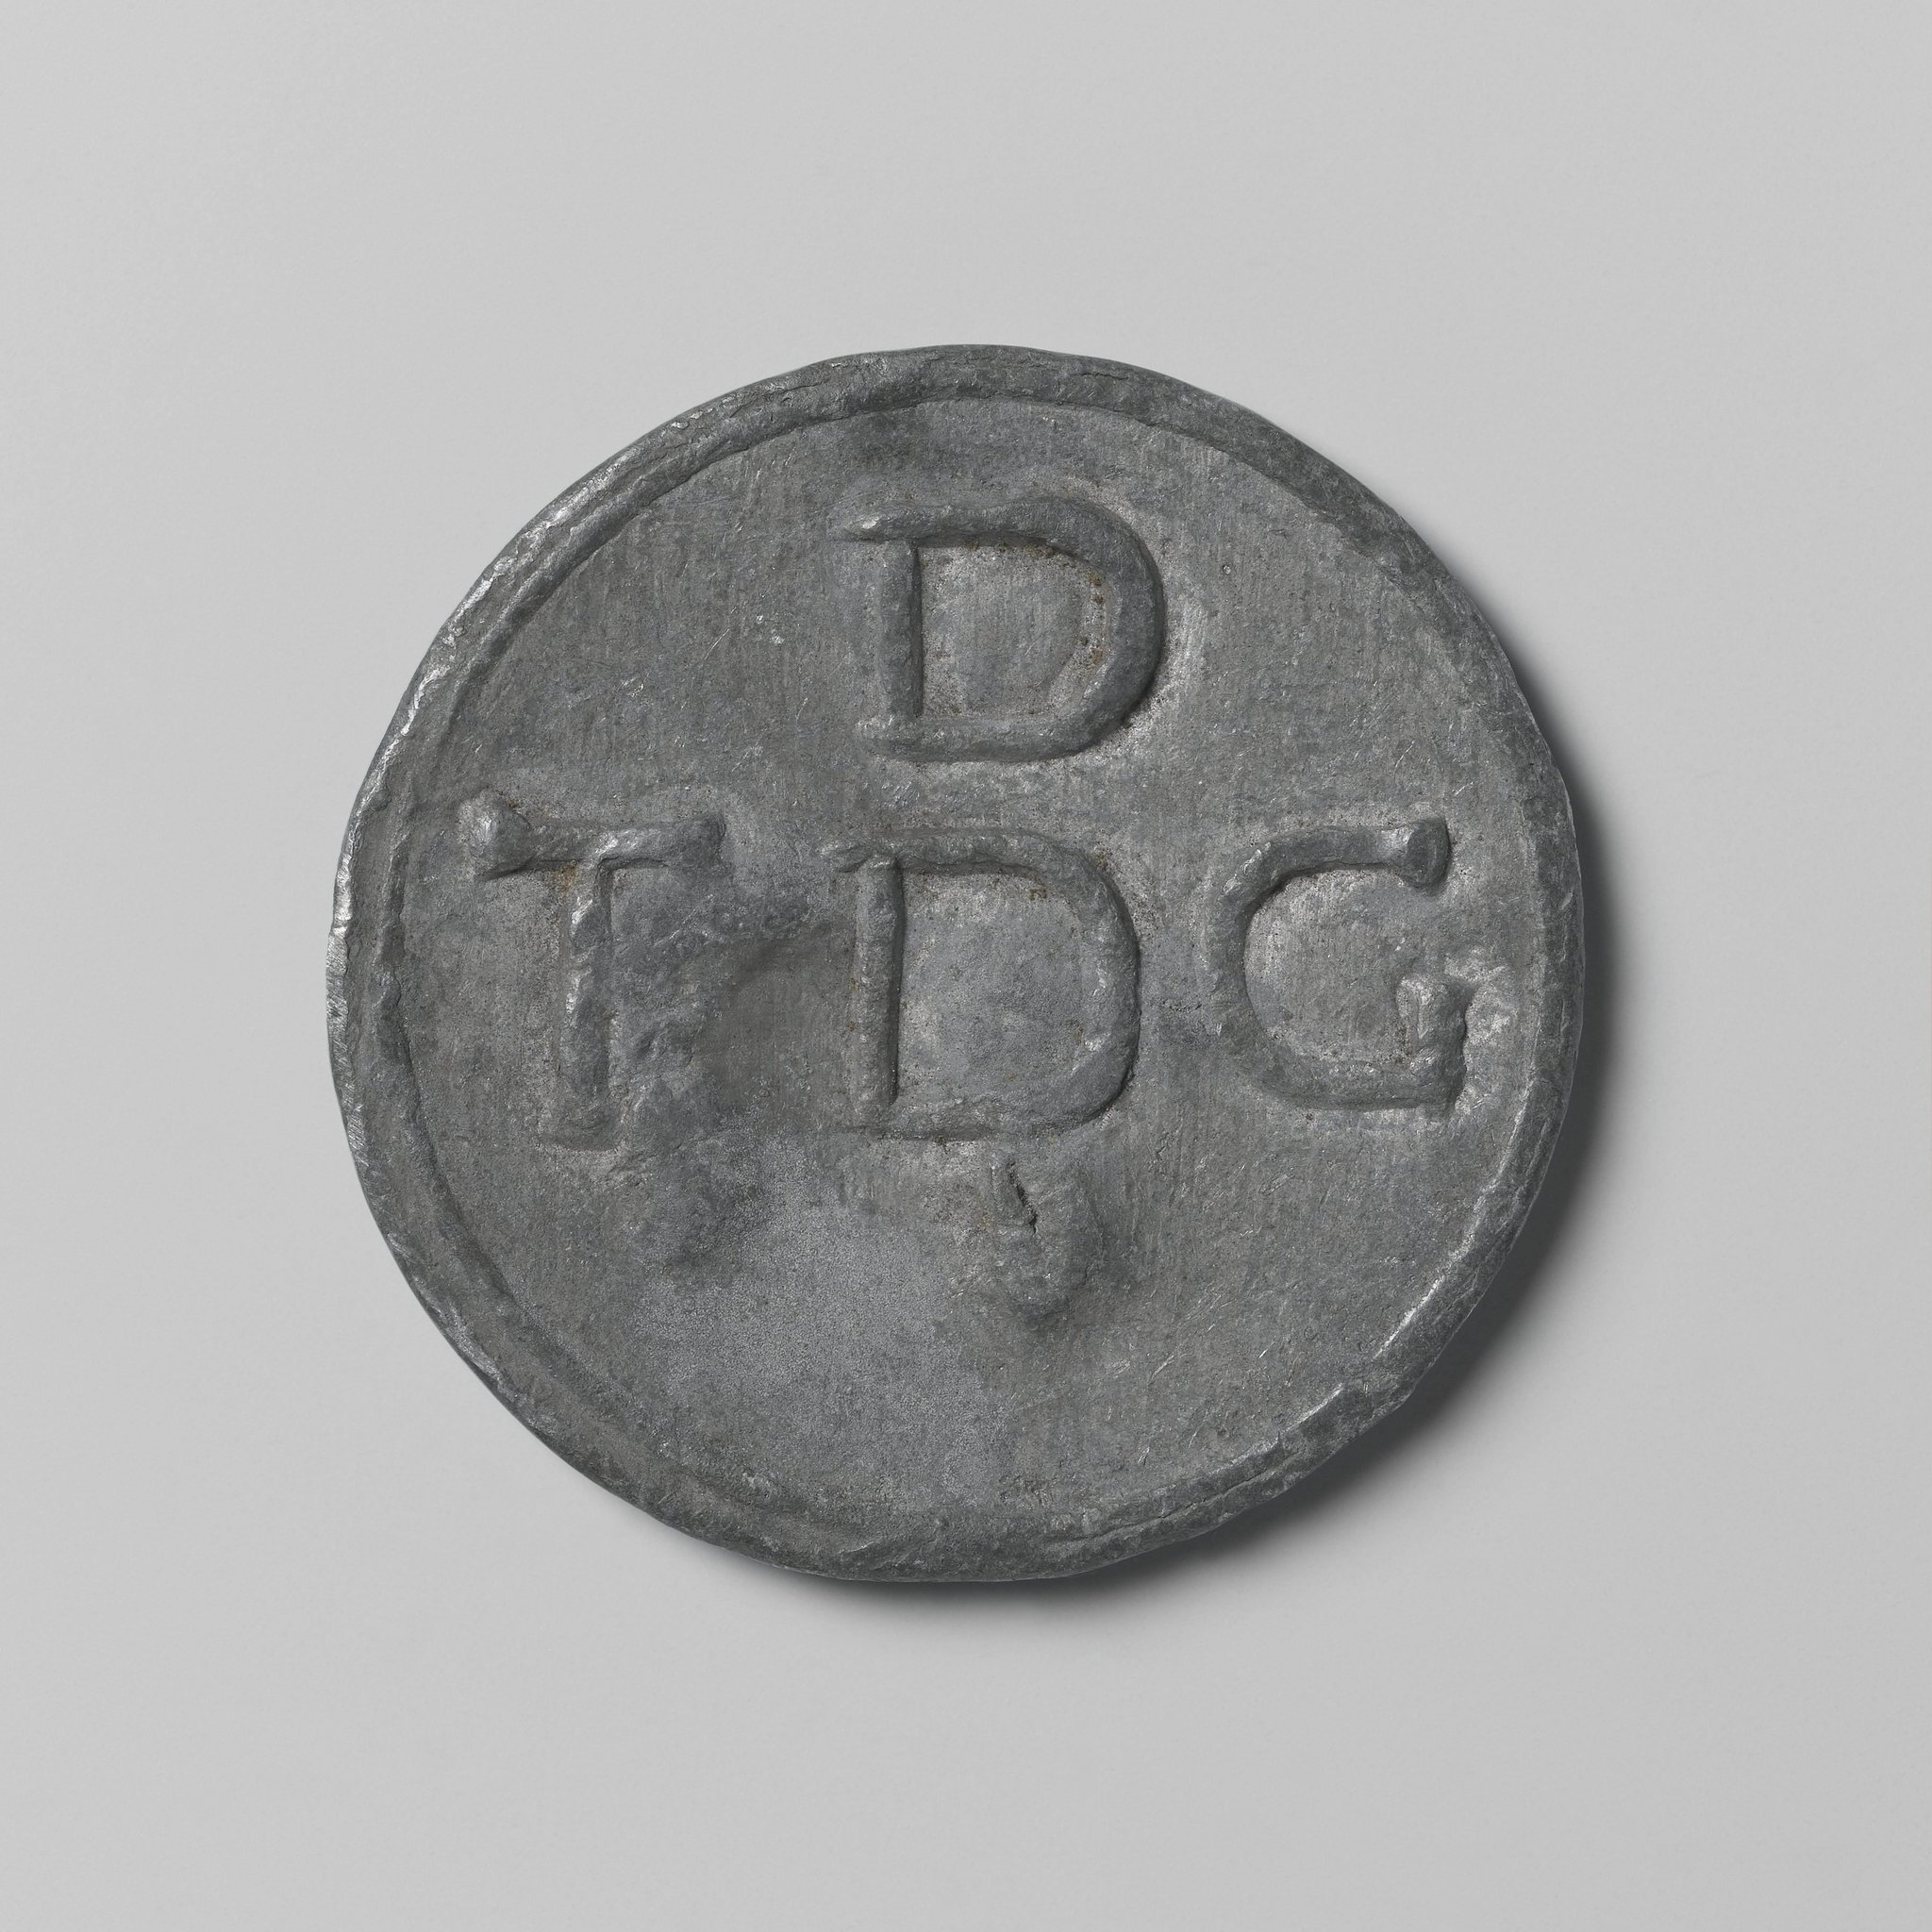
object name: medal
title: Turfdragersgilde van Amsterdam, presentiepenning met letter D en cijfer 77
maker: Anonymous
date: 1600-1800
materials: lead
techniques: casting, engraving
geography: amsterdam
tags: amsterdam